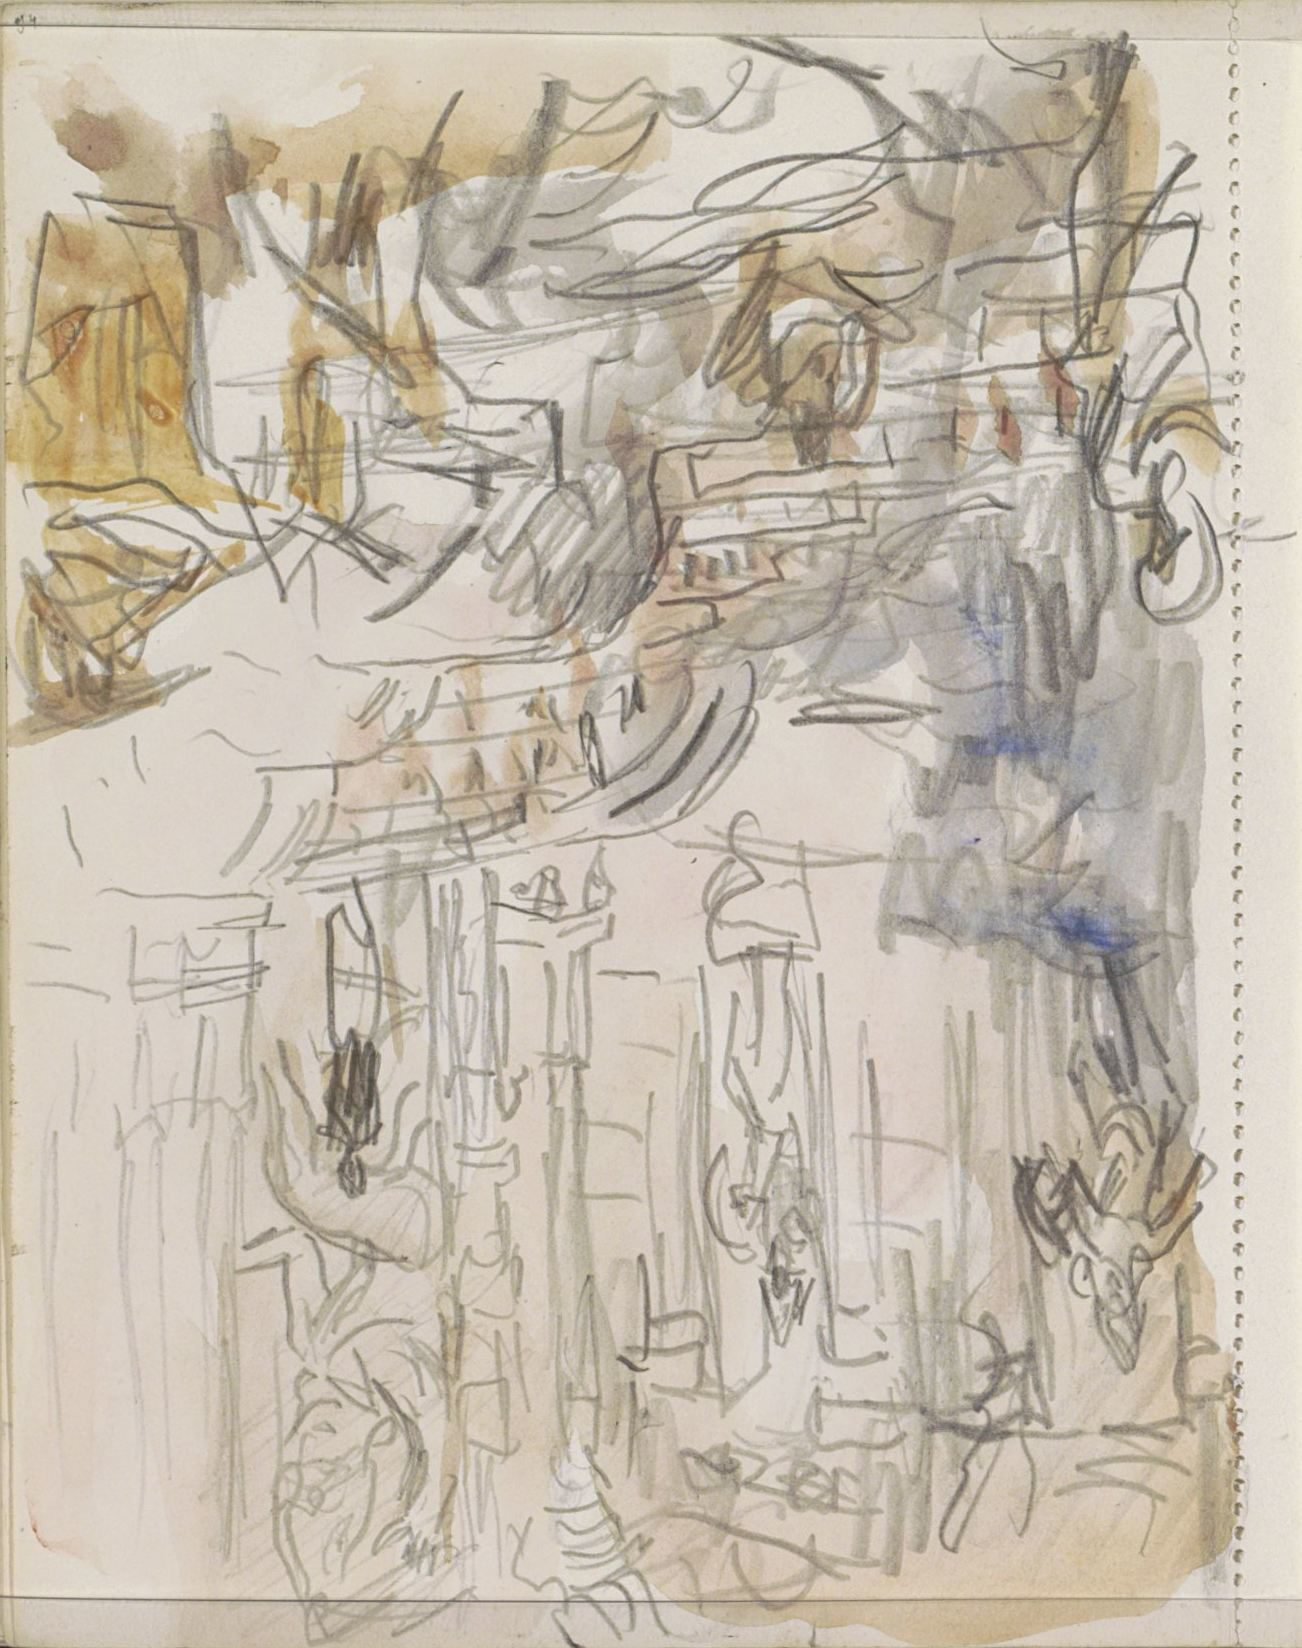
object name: sketchbook leaf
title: Voorgevel en trappen, vermoedelijk van de Brihadeeswara Tempel in Tanjore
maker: marius bauer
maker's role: draughtsman, print maker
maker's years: 1867-1932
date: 1924-1925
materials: paper, pencil, watercolor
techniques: brush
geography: thanjavur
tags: temple, shrine ~ hinduism, buddhism, jainism, flight of steps, statues, paintings, etc. ~ objects of worship (hinduism, buddhism, jainism), front façade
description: Beeldhouwwerken van Hindoeïstische goden staan tussen pilasters langs de gevel. Pagina 94 uit een schetsboek met 75 bladen.